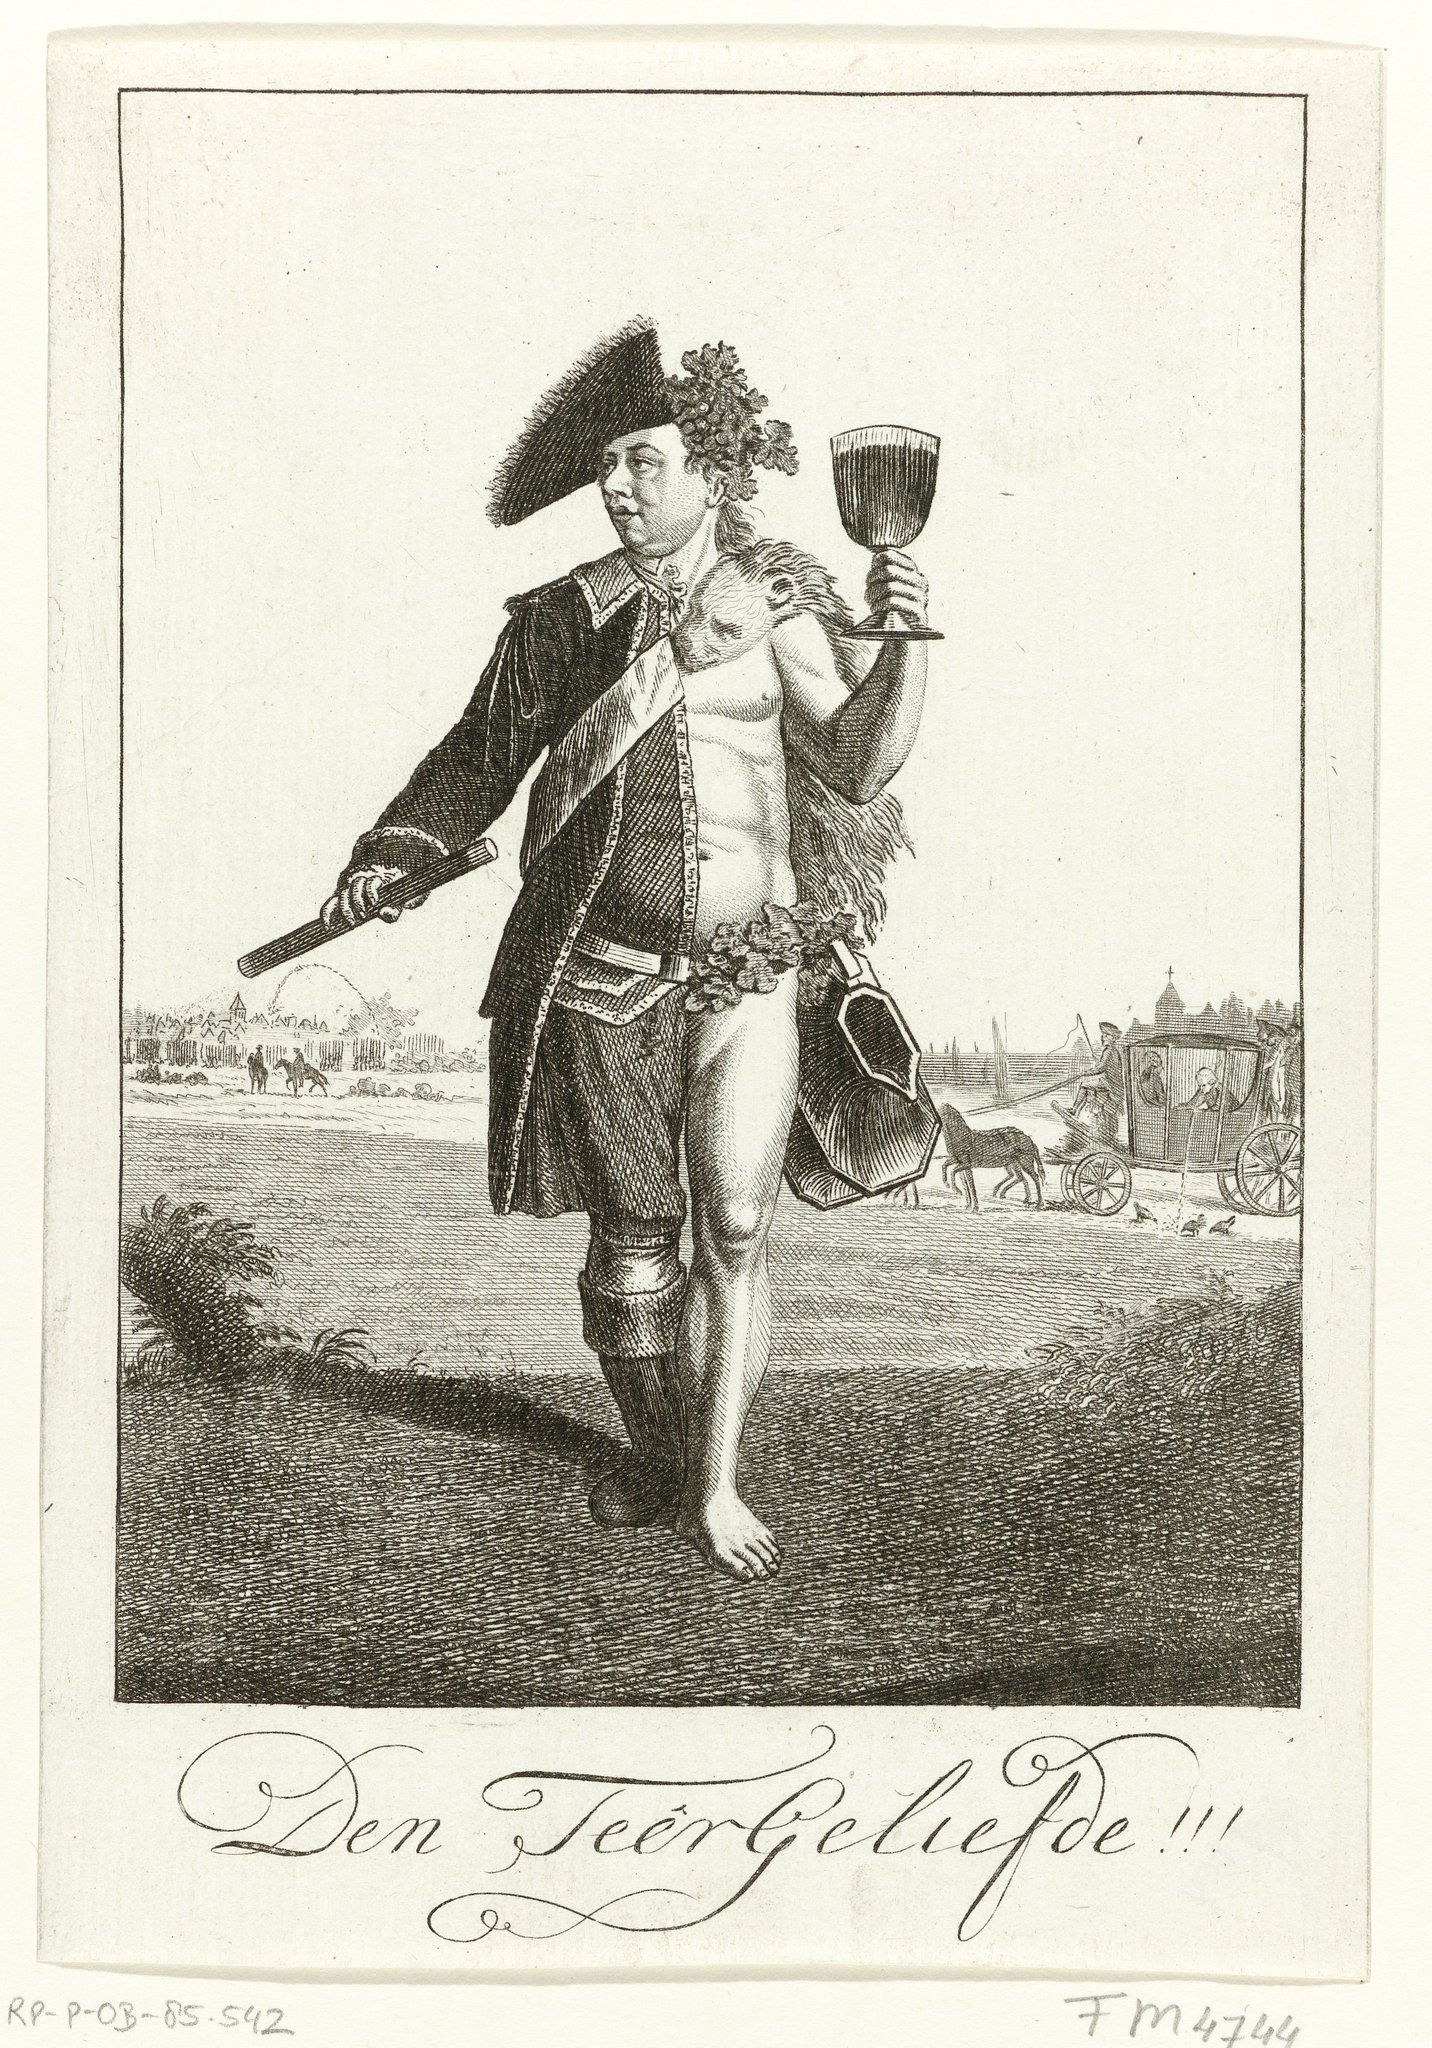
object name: cartoon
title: Satirical Print of William v, Half-soldier, Half-Bacchus, 1786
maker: Anonymous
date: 1786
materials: paper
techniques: engraving, etching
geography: northern netherlands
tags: the hague, william v (prince of orange), vomiting, drunkenness, eating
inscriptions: collector's mark: Lugt 2228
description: With his commander’s baton, Stadholder William V points to the bombardment of Hattem by his troops in 1786. His contemporaries condemned this cruel, unnecessary attack. His appearance as Bacchus, god of wine, symbolizes his profligate lifestyle. At the time, this was a common complaint about the conduct of the nobility. In the distance, the prince leans out and vomits over a coach door.